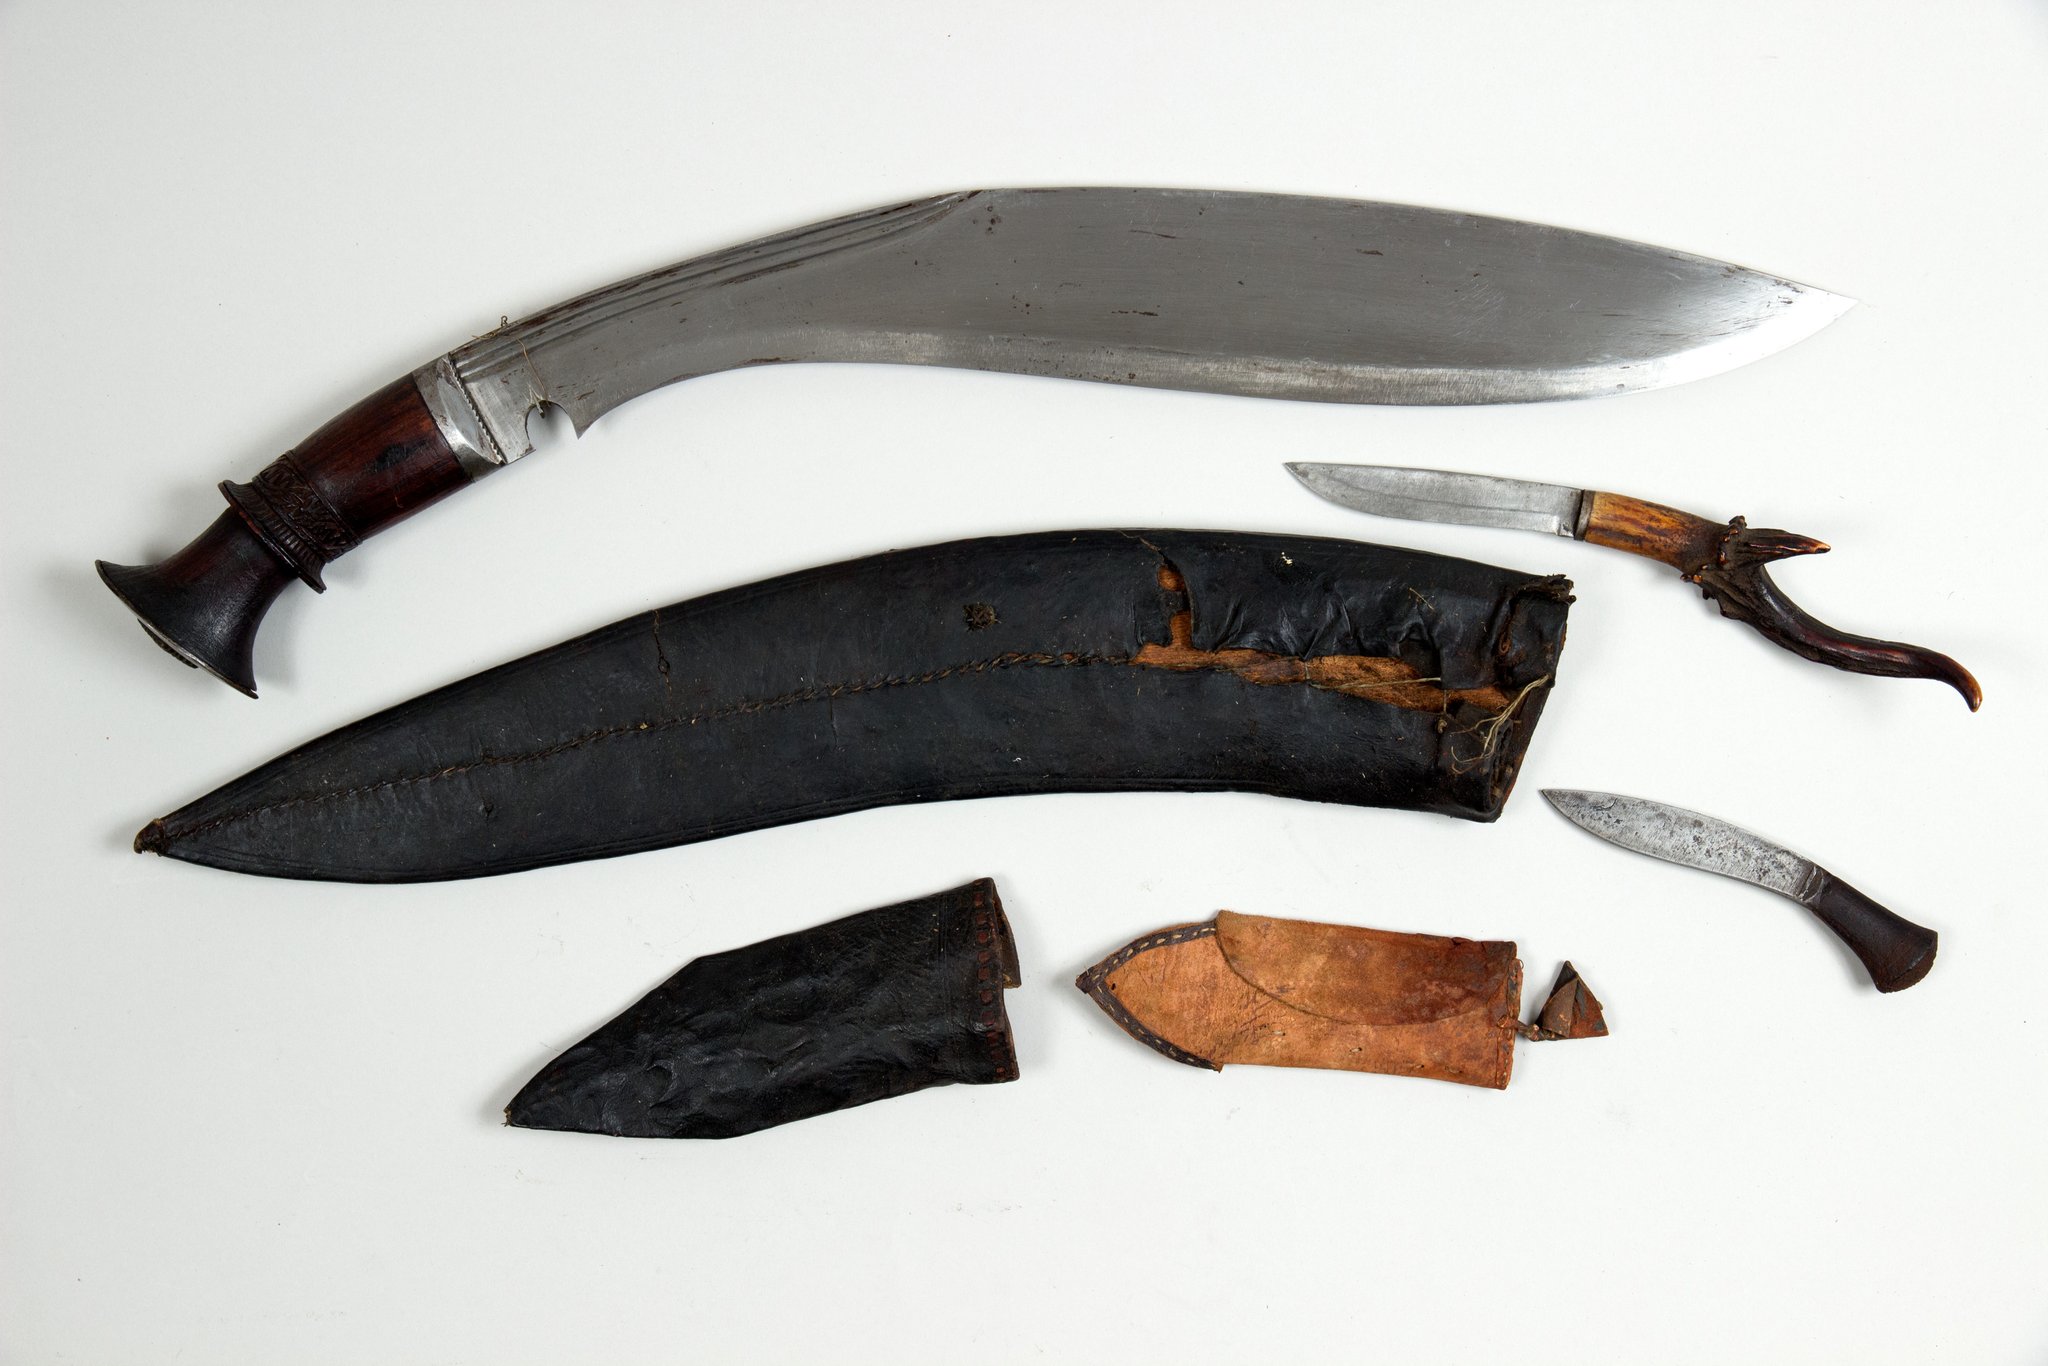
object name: knife kukri with sheath and pouch with two small knife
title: Knife (Kukri) with Sheath and Pouch with Two Small Knives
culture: gurkha or indian or nepalese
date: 1801-1900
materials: brass, horn, leather, steel, wood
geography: india